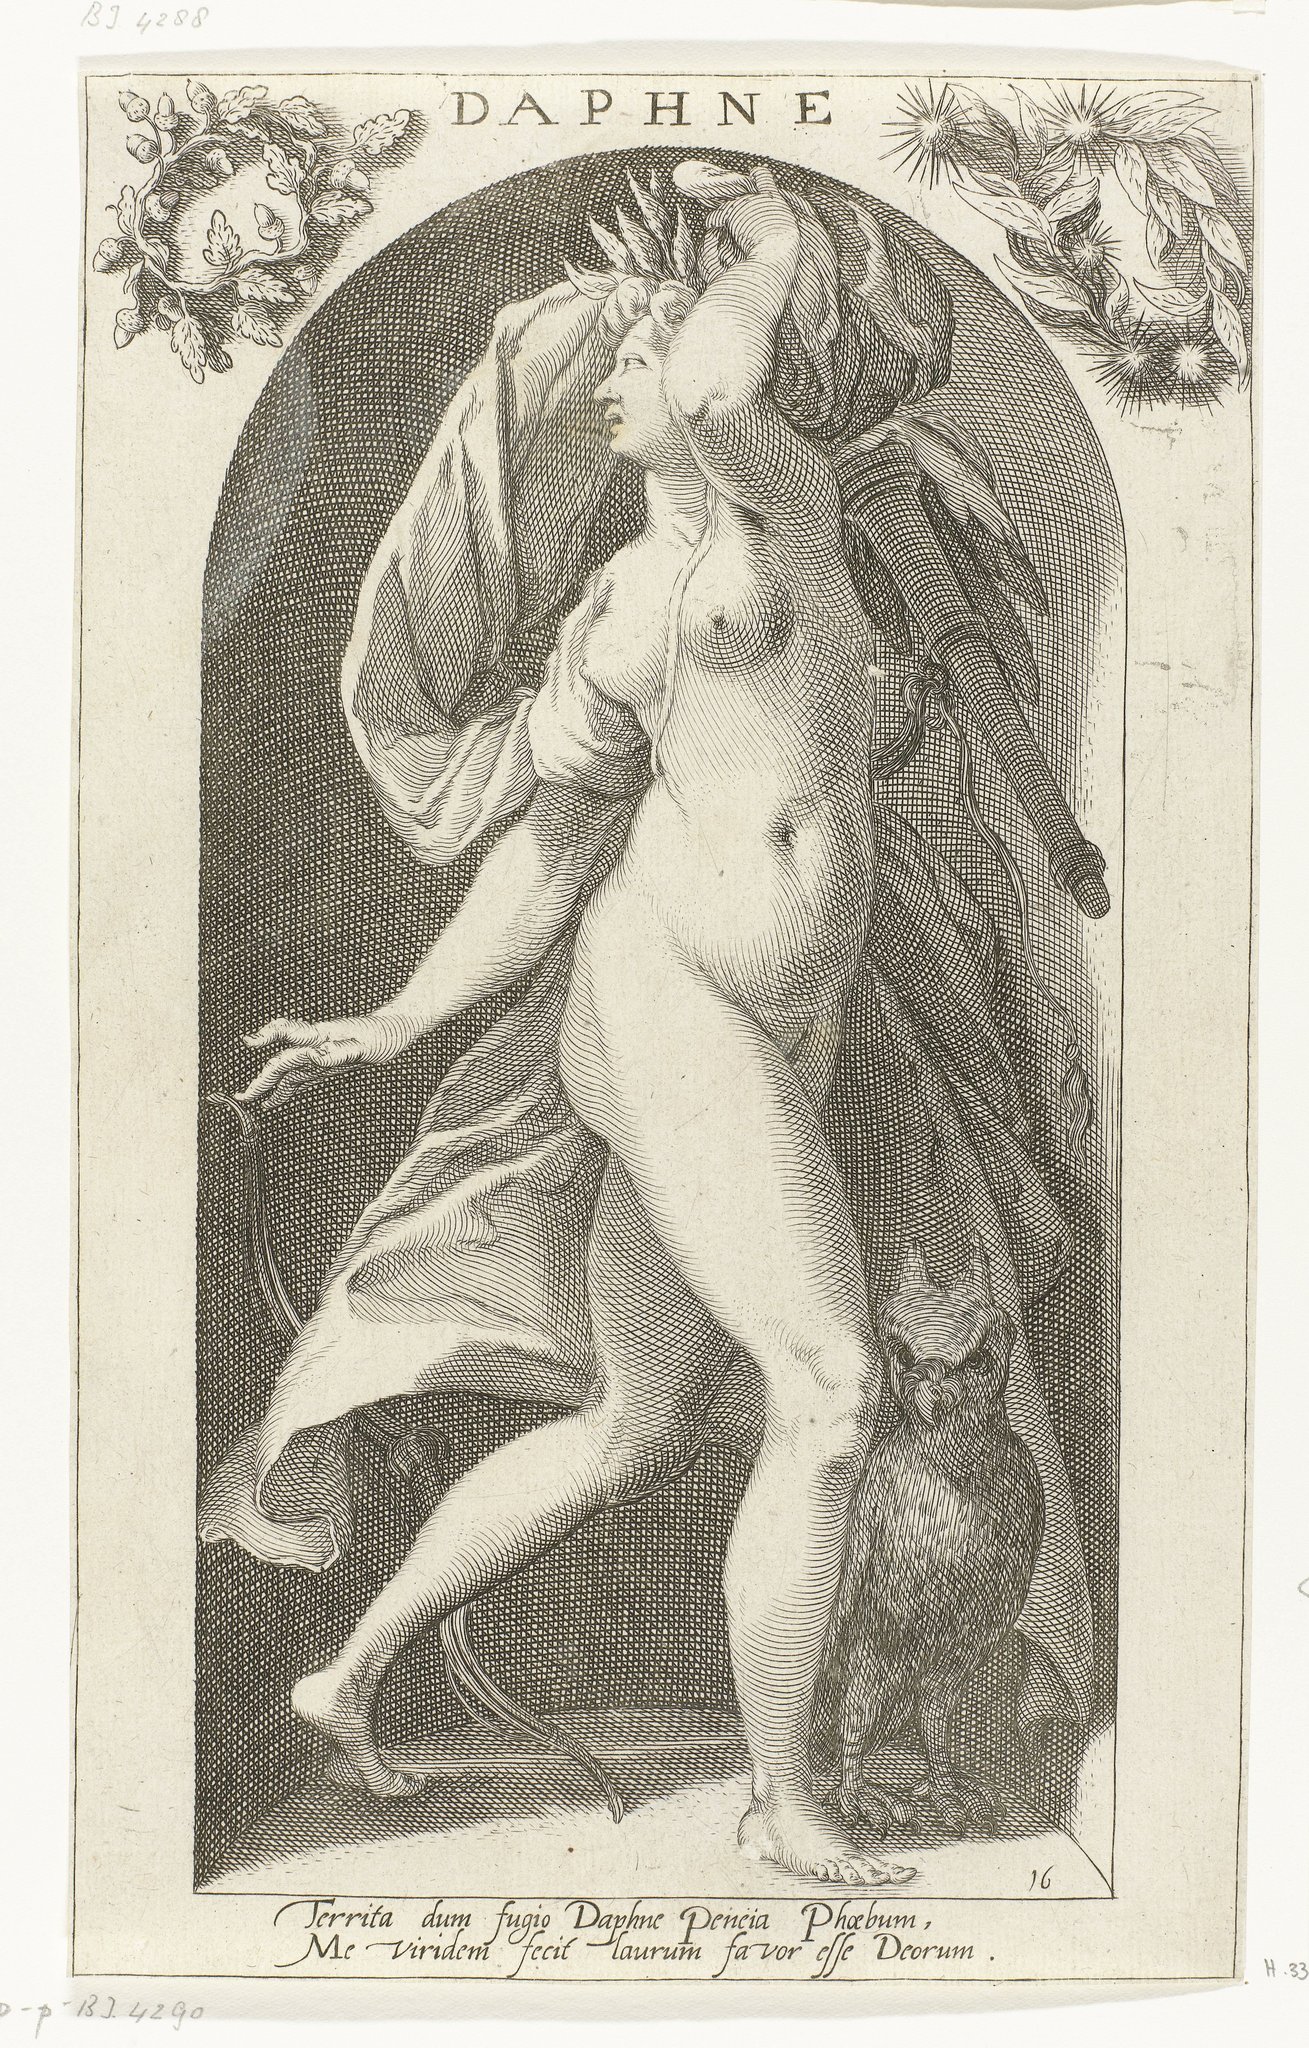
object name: print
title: Daphne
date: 1598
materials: paper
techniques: engraving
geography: haarlem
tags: single named nymphs (with name)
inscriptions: collector's mark: Lugt 2228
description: Een beeld van Apollos geliefde Daphne, in een nis geplaatst. Daphne is op de vlucht voor Apollo die haar achtervolgd. Haar vader geeft aan haar bidden gehoor en redt haar door haar te verwandelen in een laurierboom. Uit haar hoofd beginnen al laurierbladen te sprieten. Ze draagt een pijlenkoker en boog als verwijzing naar Apollo. Naast haar staat een oehoe. Met Latijns onderschrift.